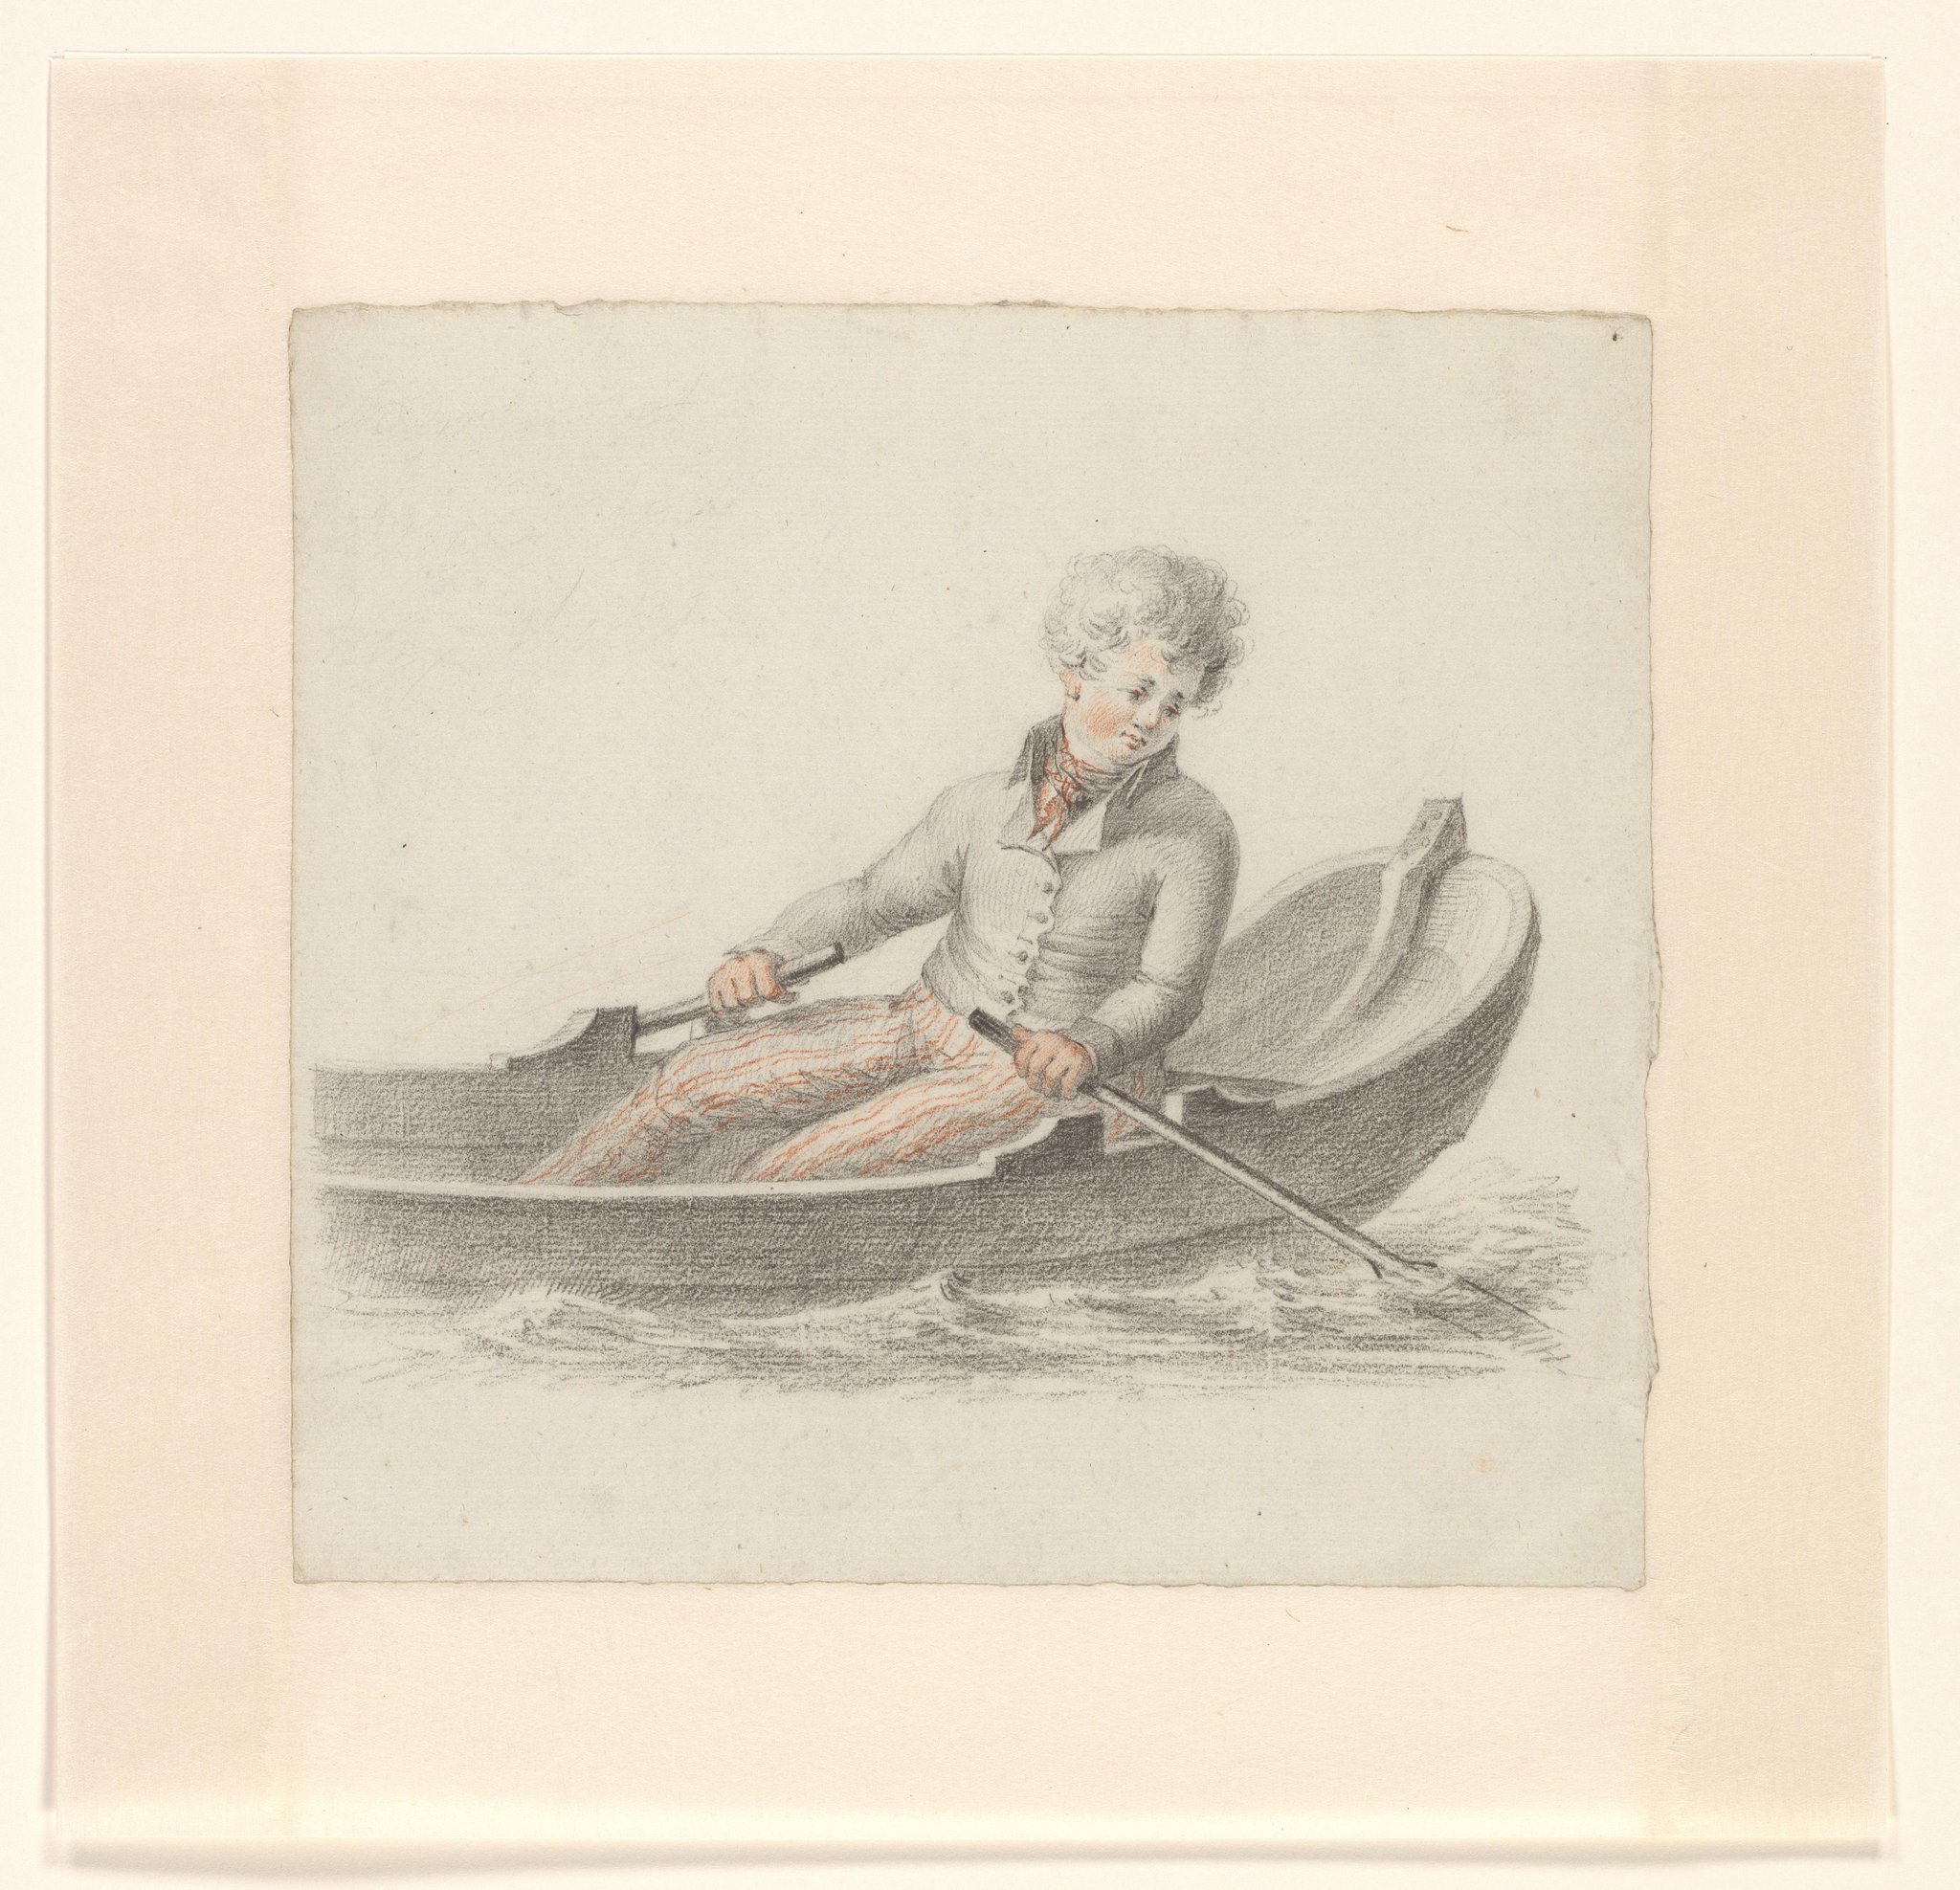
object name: drawing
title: Jongen in een roeiboot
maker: johannes van reijn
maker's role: draughtsman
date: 1800-1900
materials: chalk, paper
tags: boy (child between toddler and youth), rowing-boat, canoe, etc.